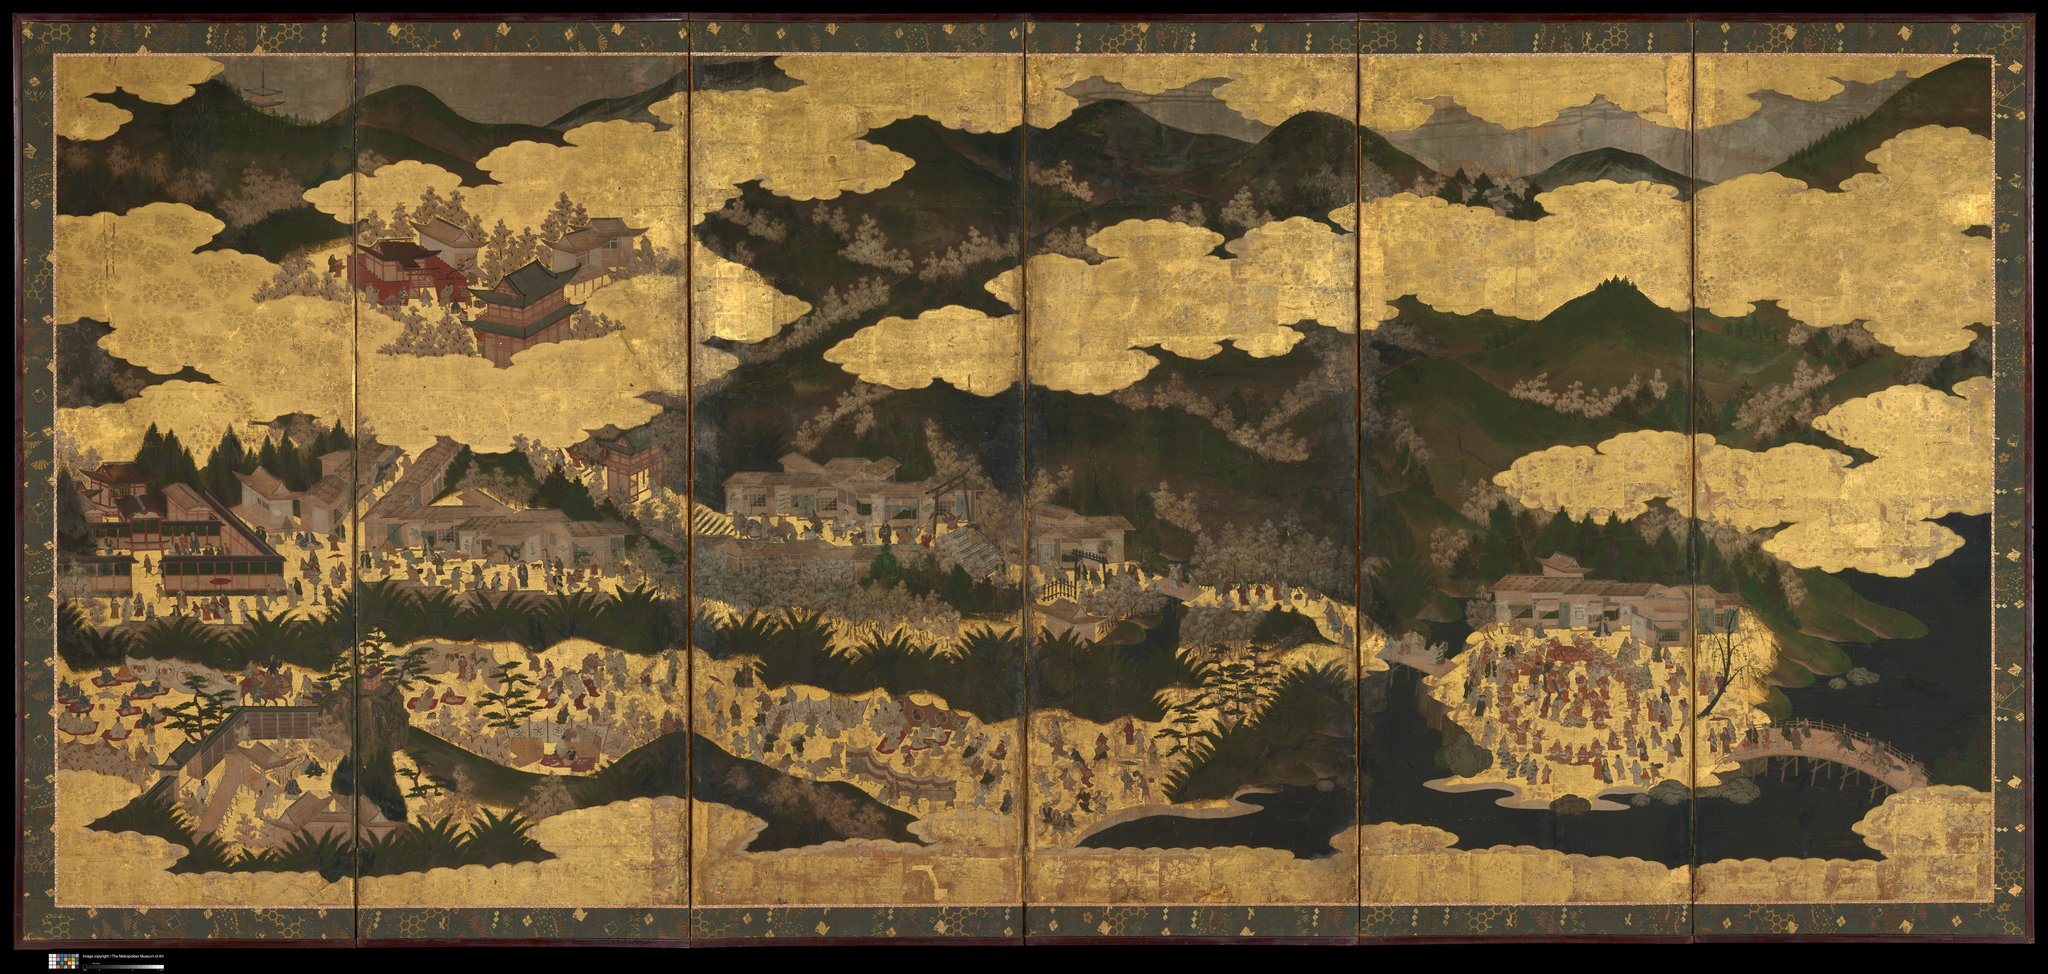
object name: screen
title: Cherry Blossom Viewing at Itsukushima and Yoshino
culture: japanese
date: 1601-1650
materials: gold leaf, ink, panel, paper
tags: houses,trees